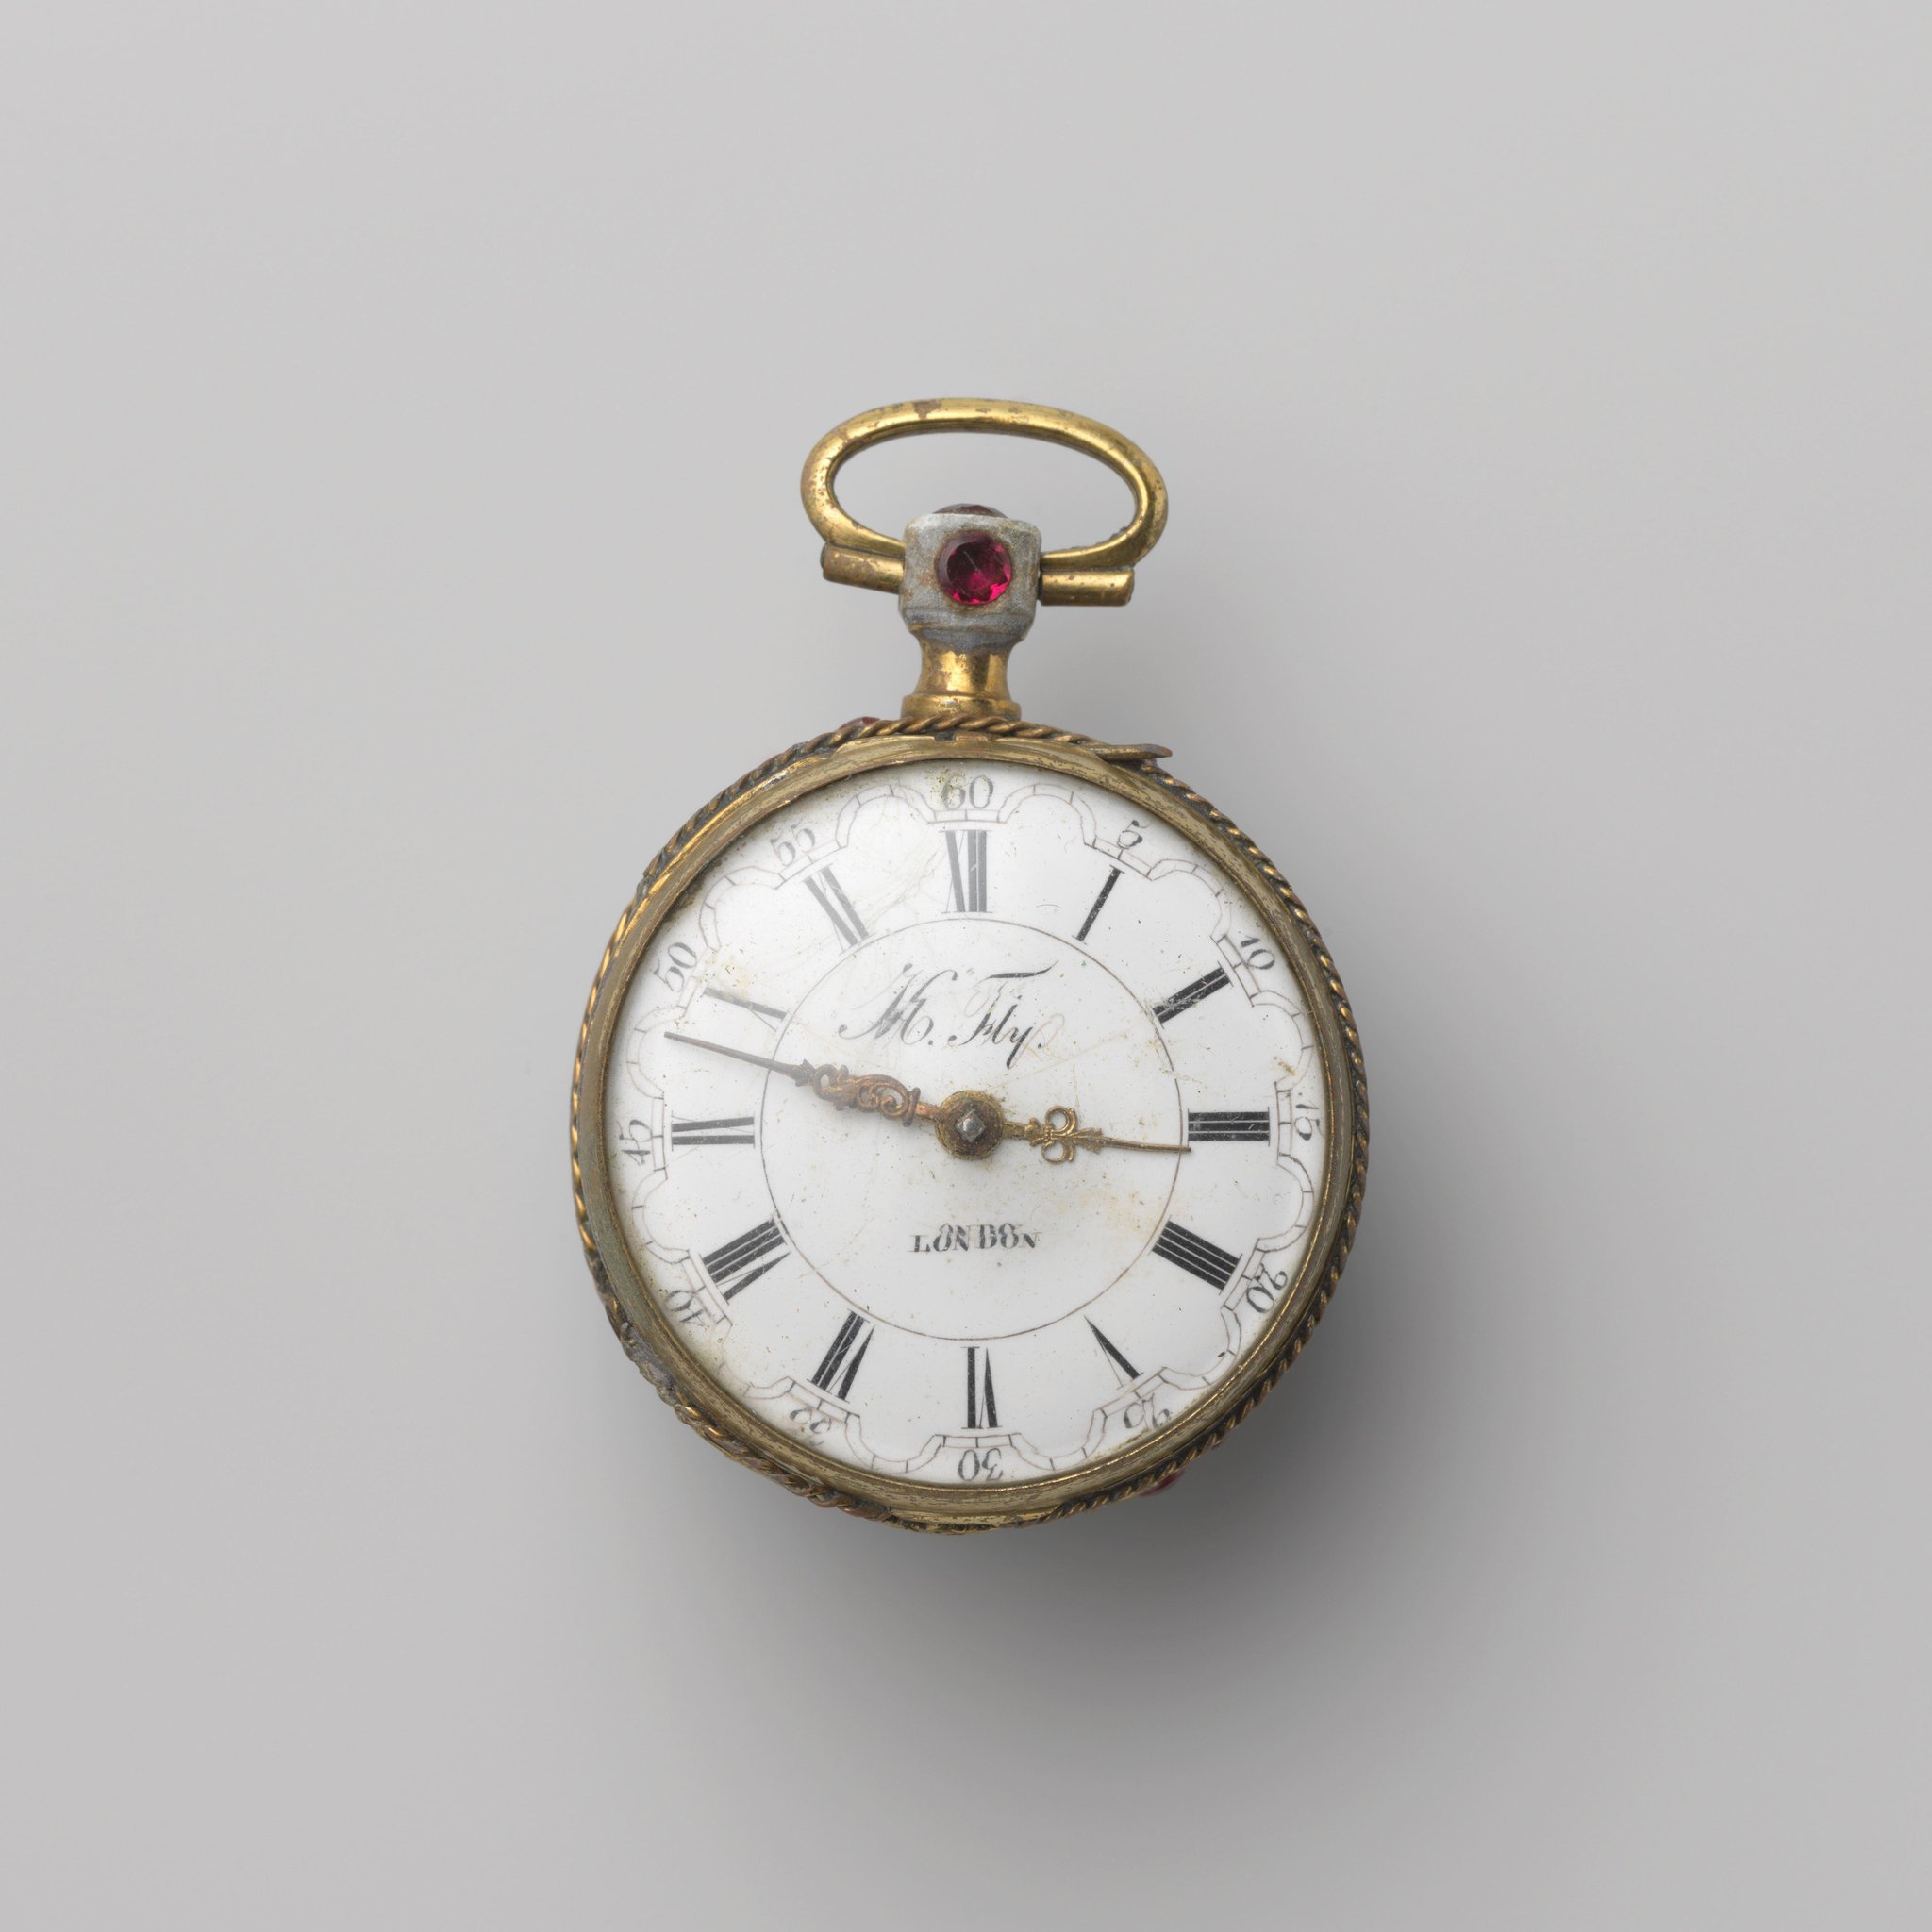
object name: jewellery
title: Horloge van verguld koper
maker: h. fly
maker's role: clockmaker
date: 1800-1900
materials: copper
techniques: gilding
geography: london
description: Verguld koperen horloge met geëmailleerde wijzerplaat. Op de achterbodem een draaibare geciseleerde roset met daar omheen een slang.